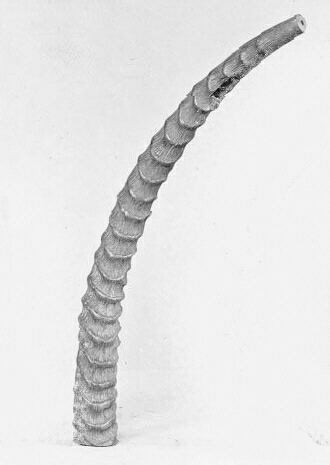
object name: horn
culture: congolese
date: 1867-1900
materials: horn